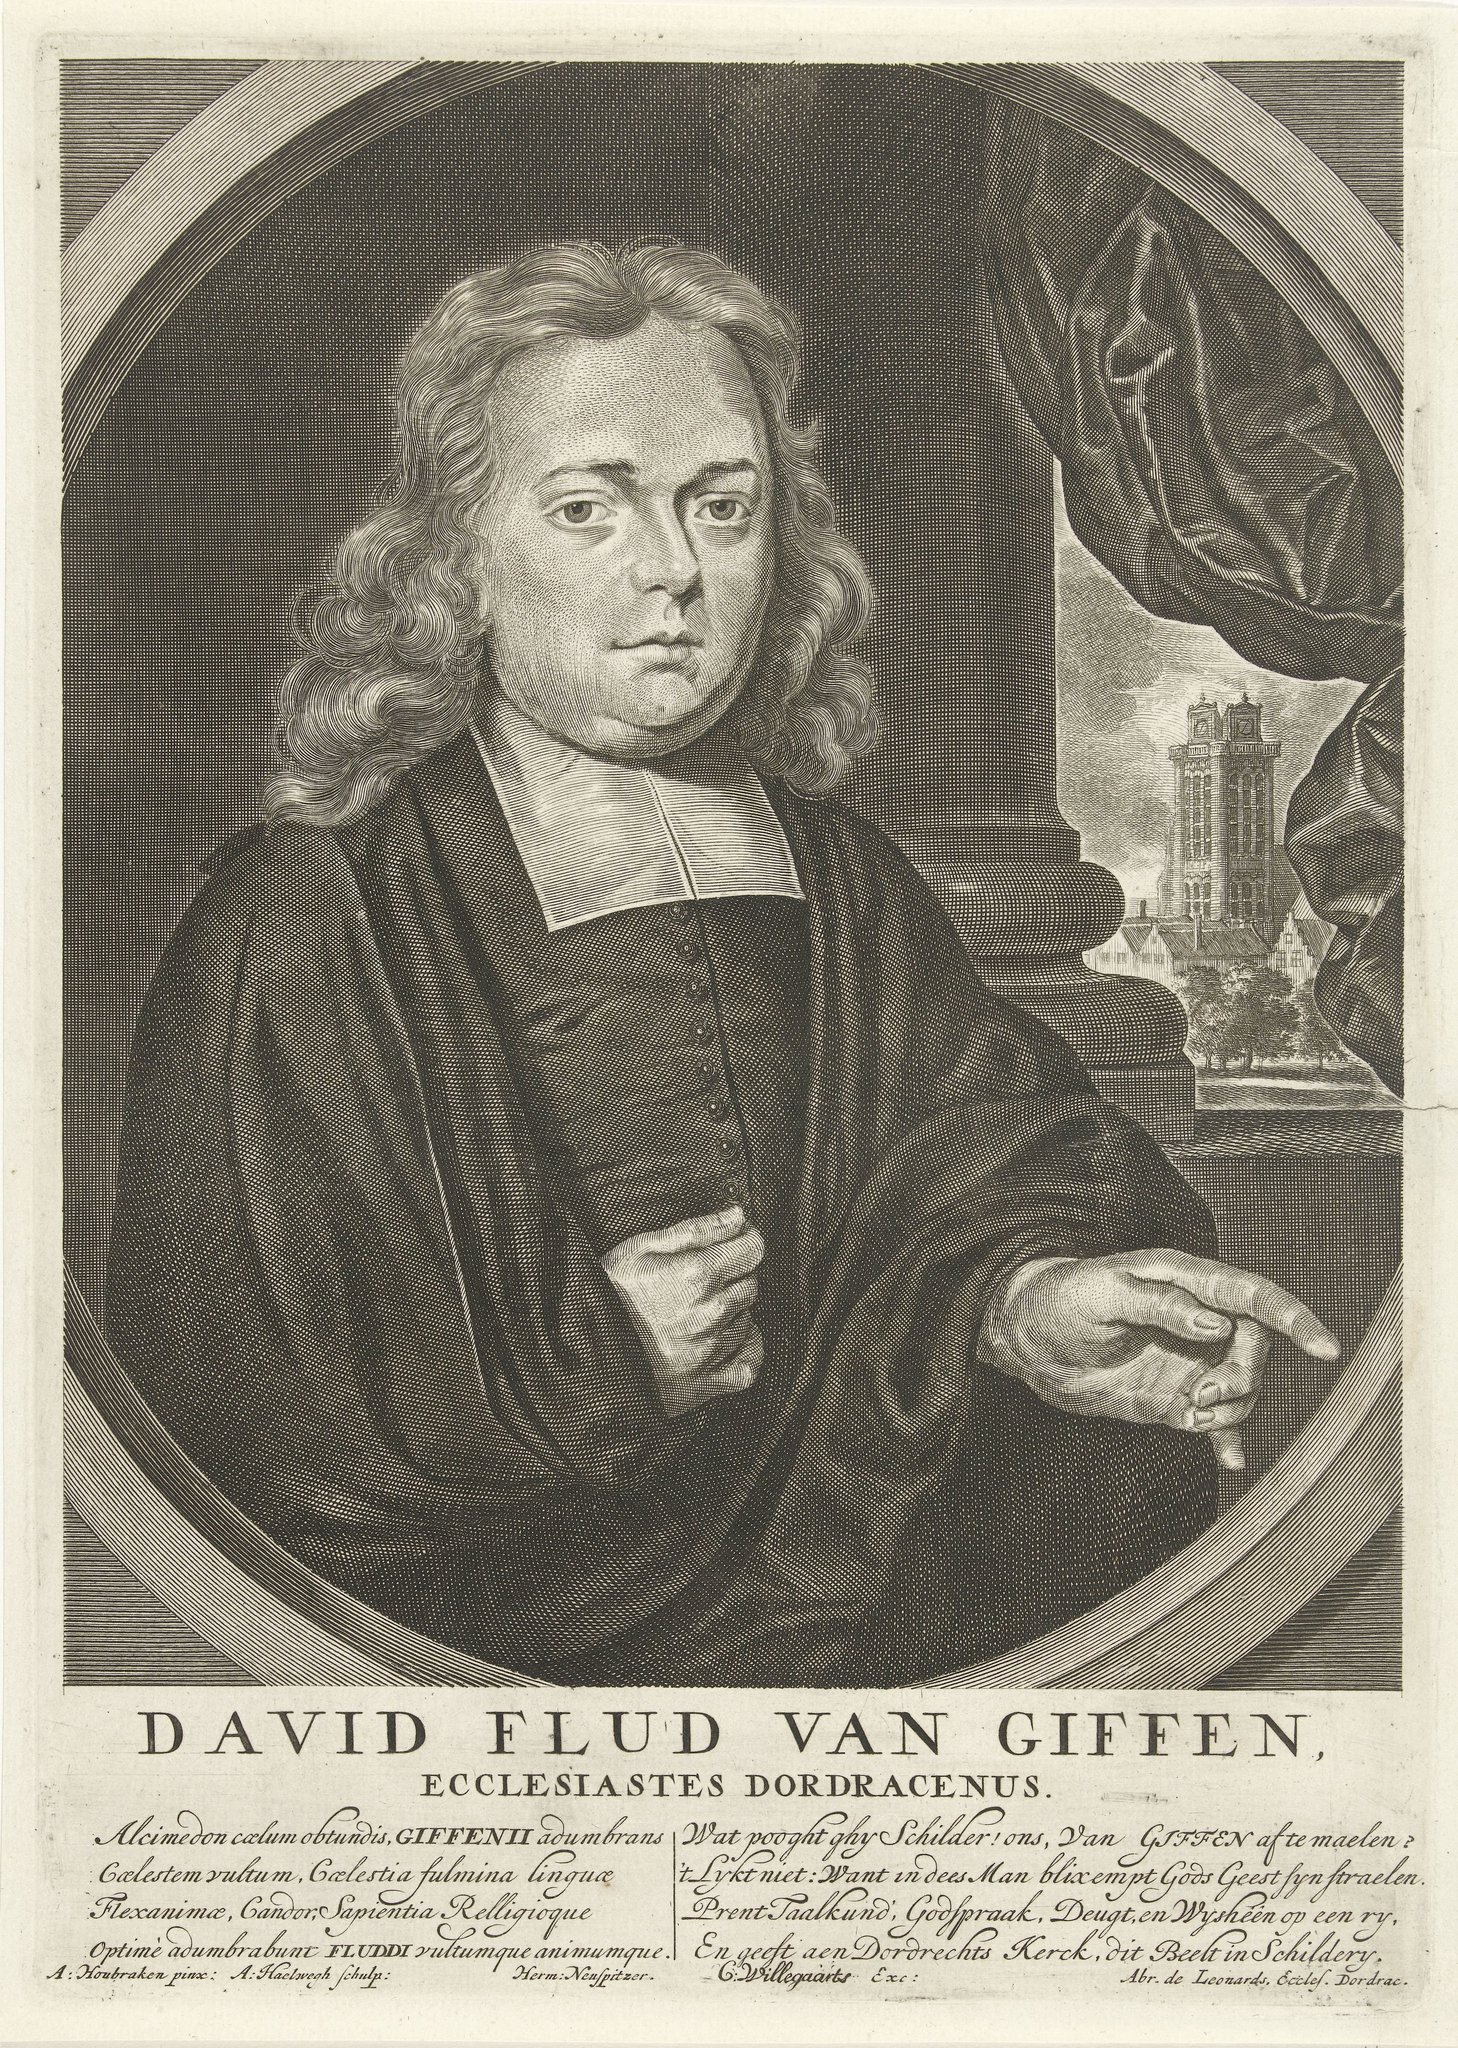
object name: print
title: Portret van David Flud van Giffen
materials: paper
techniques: engraving, etching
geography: dordrecht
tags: building of church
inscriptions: collector's mark: Lugt 2228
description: Portret ten halven lijve naar rechts van de theoloog David Flud van Giffen, in een ovaal, met op de achtergrond een doorkijk langs een zuil op de Grote Kerk van Dordrecht. Onderaan zijn naam en een vierregelige tekst, links in Latijn, rechts in het Nederlands.